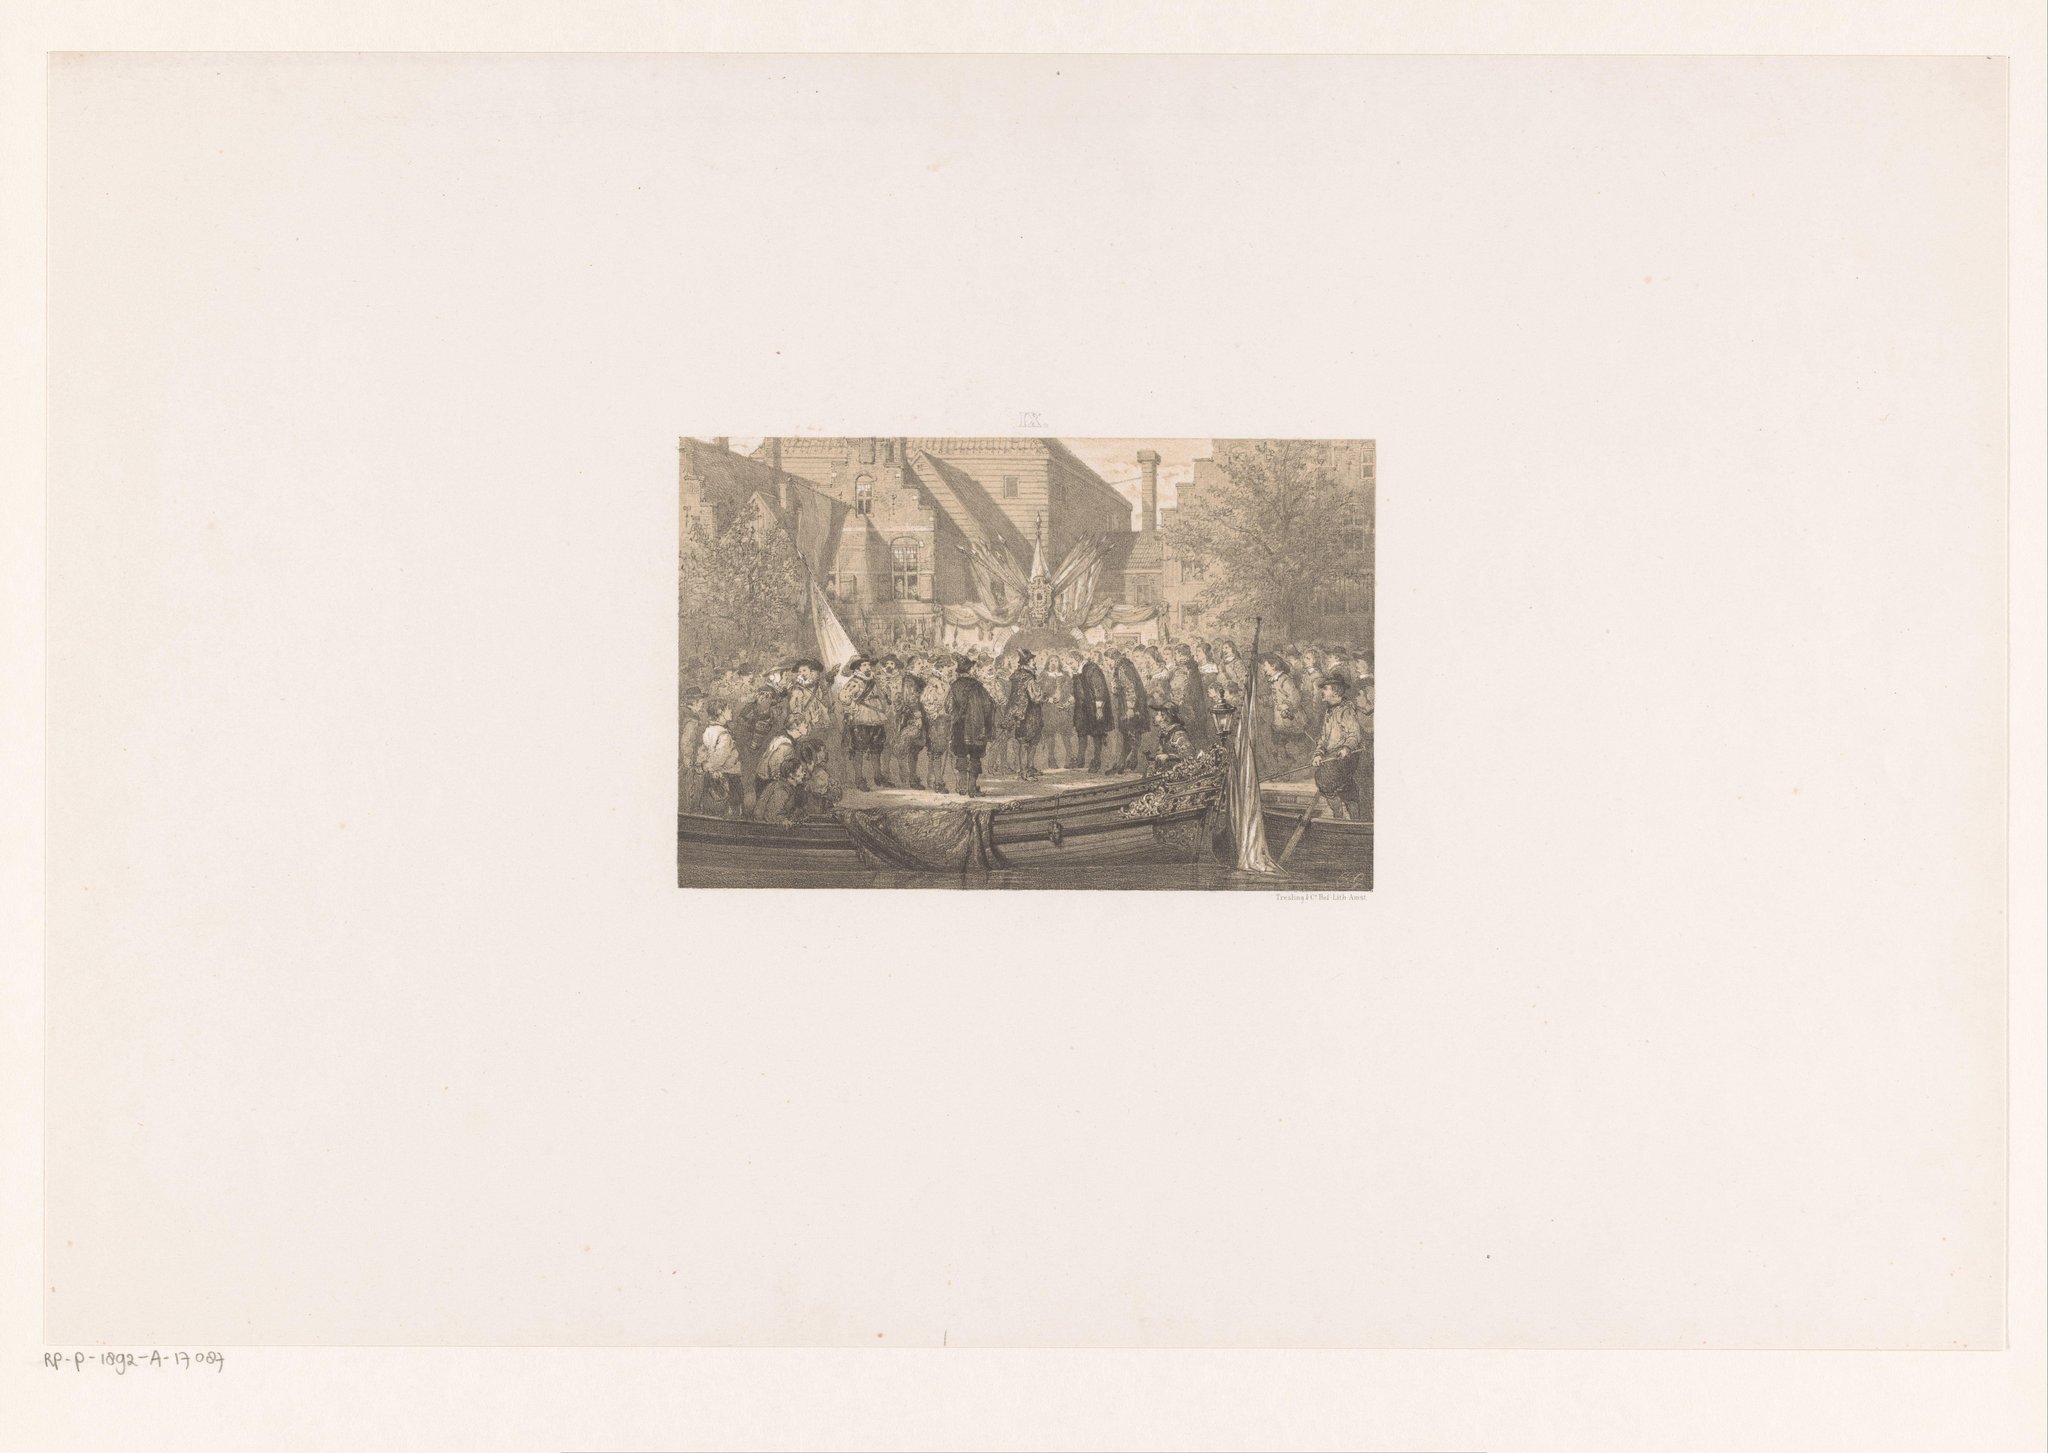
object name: print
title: Feestelijk ontvangst Prins Maurits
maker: johan conrad greive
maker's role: draughtsman, painter, print maker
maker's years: 1837-1891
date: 1876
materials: paper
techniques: tone lithography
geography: amsterdam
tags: the hague, maurice (prince of orange), samuel coster, crowd, mob, being welcomed ~ travelling, city-walls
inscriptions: collector's mark: Lugt 2228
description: In de voorgrond ligt een boot in het water. Voor een versierde stadpoort wordt prins Maurits welkom geheten door Samuel Coster. Om hen heen staat een menigte.